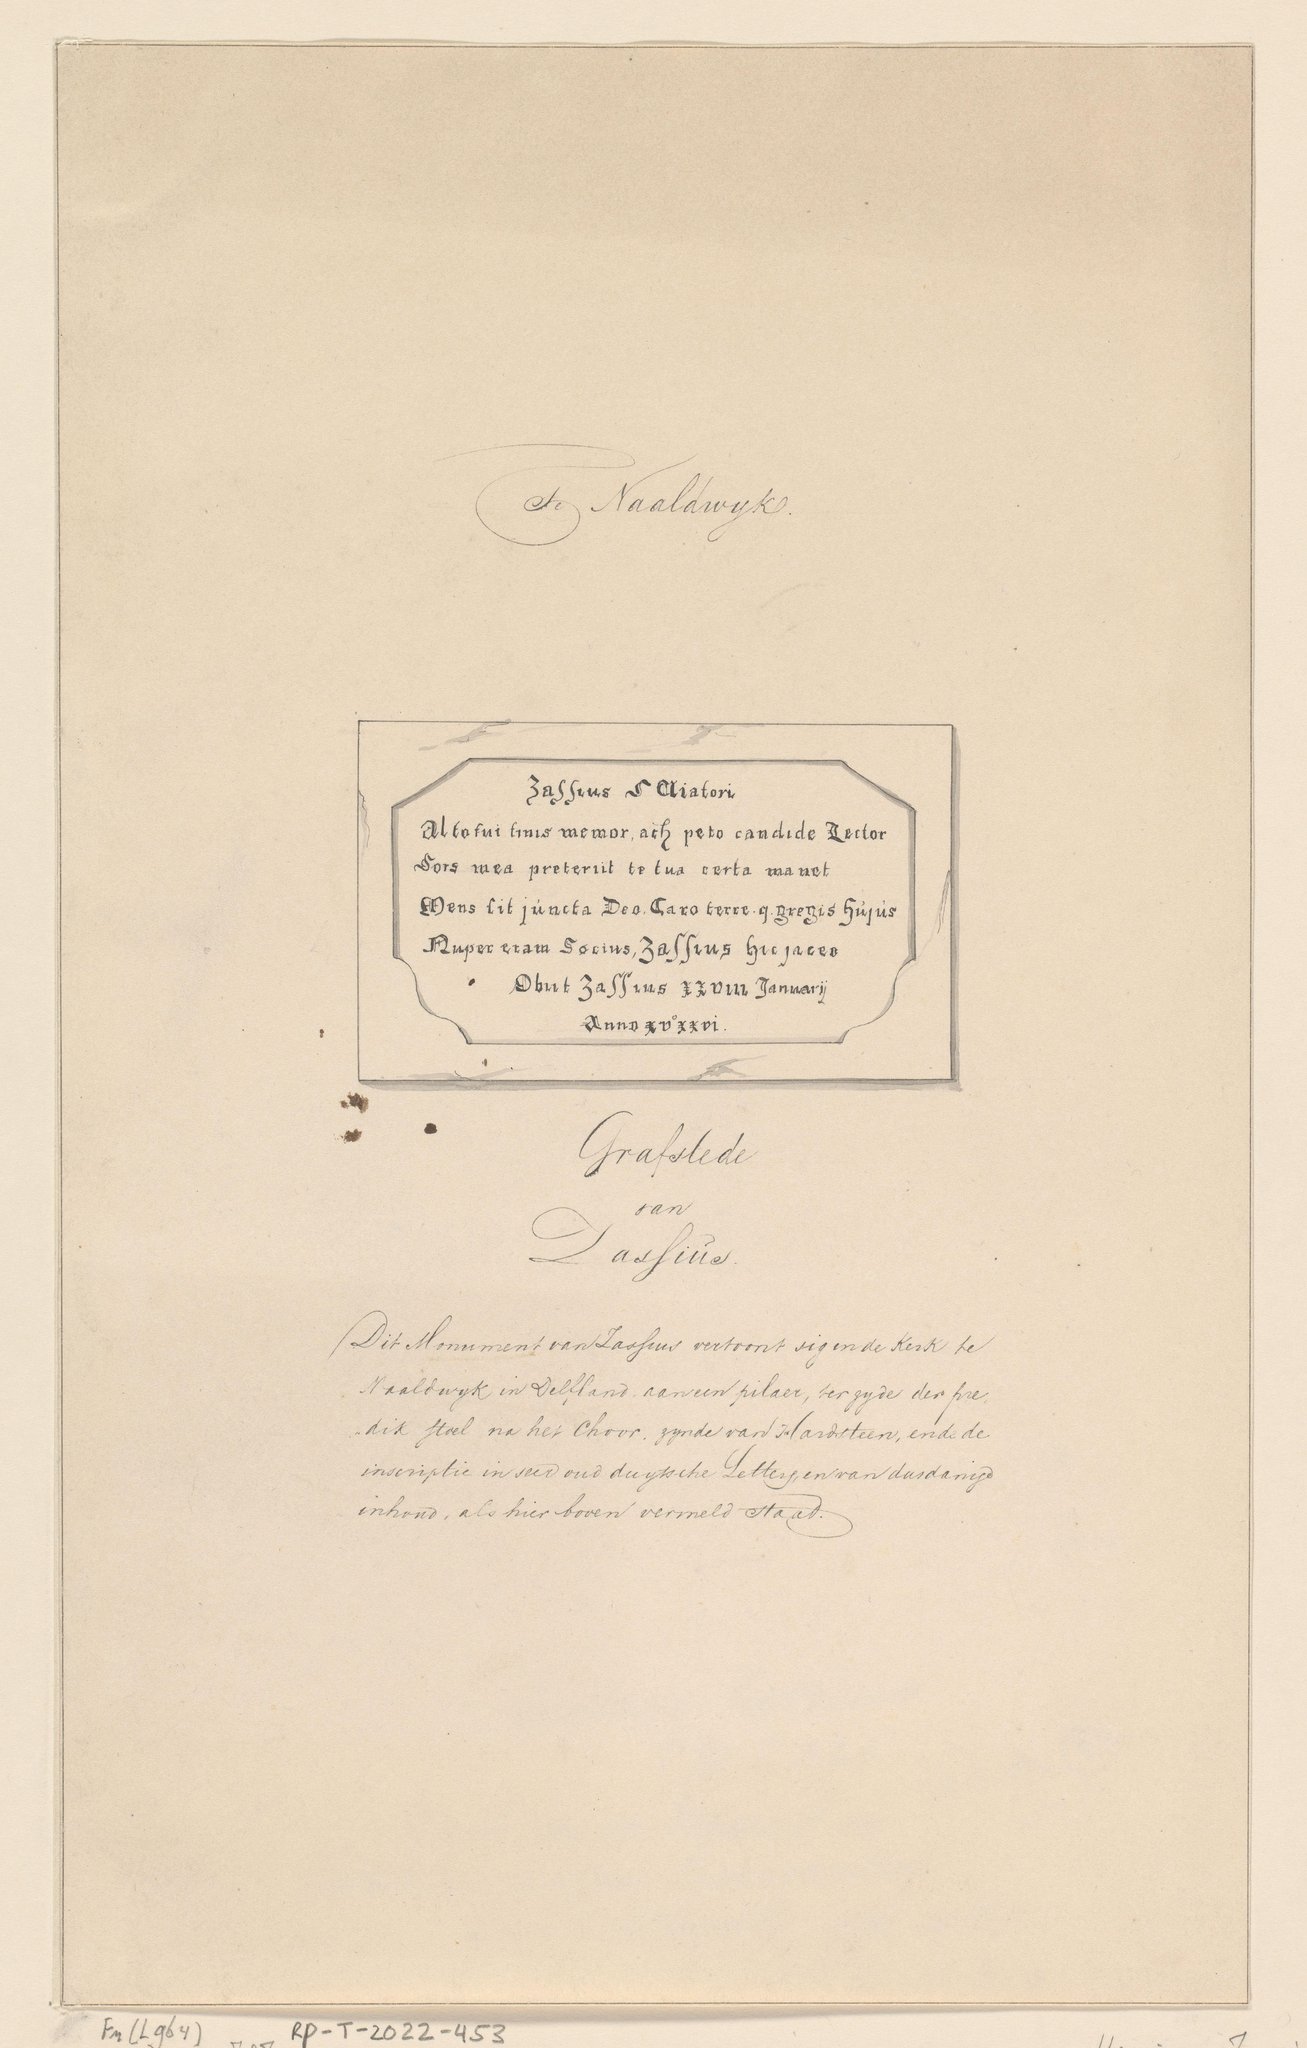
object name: drawing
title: Gedenkplaat van Henricus Zassius in de Oude Kerk te Naaldwijk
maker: Anonymous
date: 1750-1850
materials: ink, paper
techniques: brush, pen, writing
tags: historical persons, grave, tomb and other grave-forms and grave-markers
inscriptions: inscription: ‘April = 89’, collector's mark: Lugt 964, inscription: ‘Te Naaldwijk (...) Grafstede/ van/ Zassius/ Dit Monument van Zassius vertoont sig in de kerk te/ Naaldwijk in Delfland aan een pilaer, ter zijde der pre/ dik stoel na het choor, zijnde van zandsteen, ende de/ inscriptie in seer oud duytsche Letters, en van dusdanige/ inhoud, als hier boven vermeld staat.’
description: Met vierregelig vers in het Latijn, met hieronder een Nederlands bijschrift.